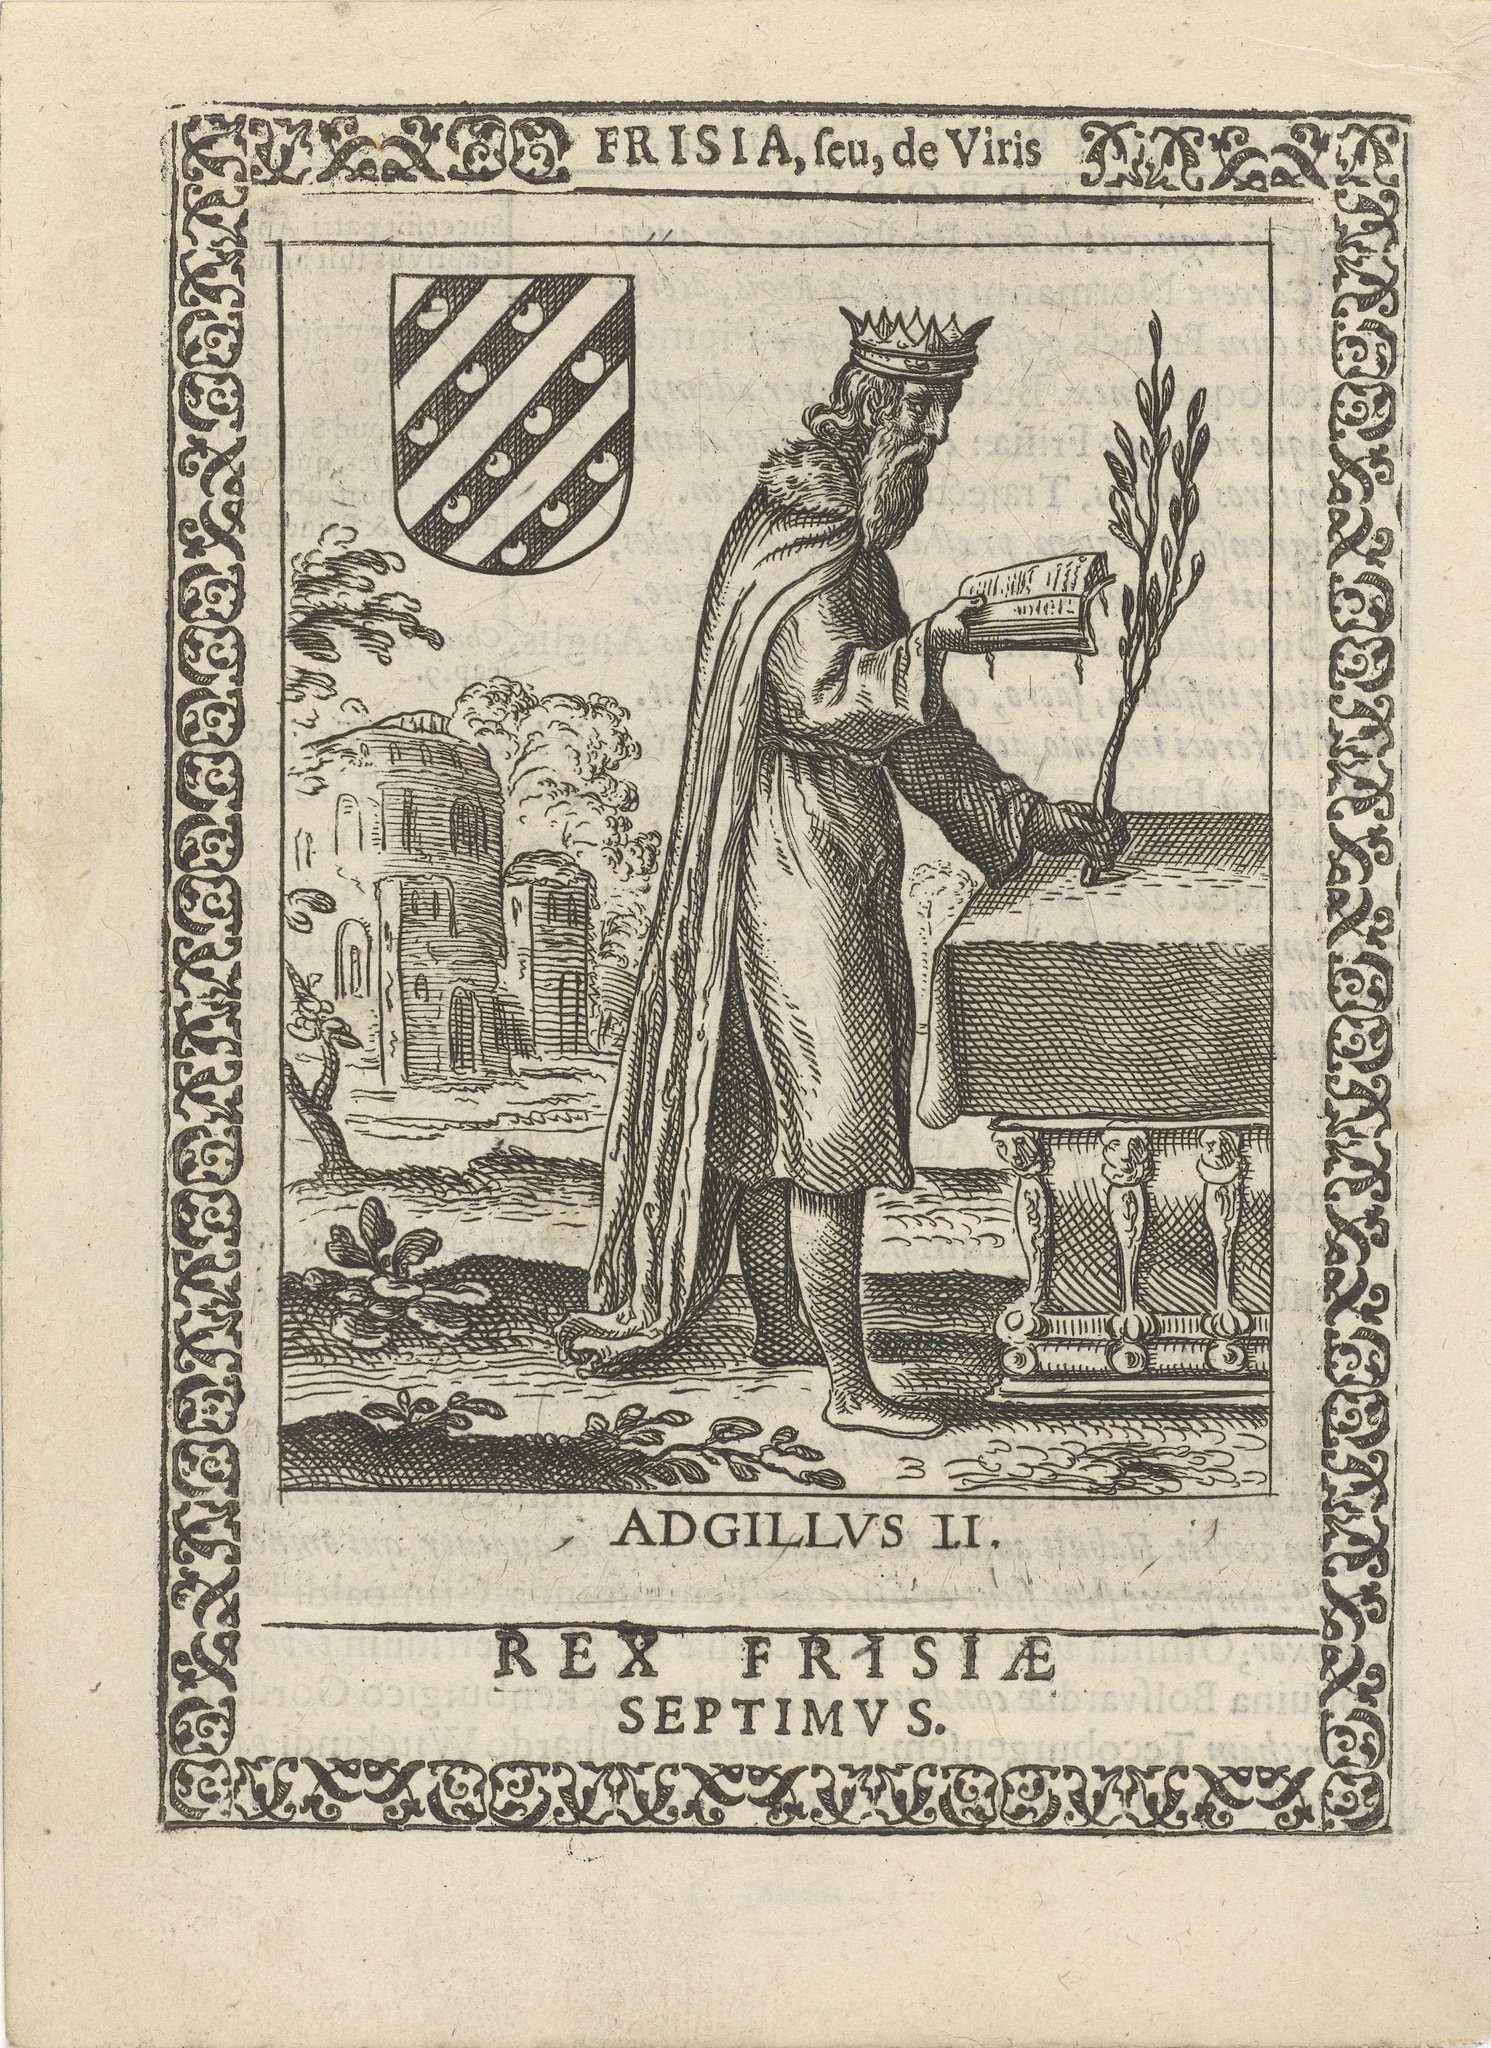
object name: book illustration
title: Koningen en Potestaten van Friesland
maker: pieter feddes van harlingen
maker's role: painter, print maker, publisher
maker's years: 1586-1623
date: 1618-1620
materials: paper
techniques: etching, letterpress printing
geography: friesland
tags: ruler, sovereign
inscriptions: collector's mark: Lugt 2228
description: Adgillis II, zevende koning der Friezen. Staande ten voeten uit, tak en boek in de hand. In een ornamentale omlijsting. Illustratie, met tekst op achterzijde, afkomstig uit het boek: Frisia seu de viris rebusque Frisiae illustribus libri duo.